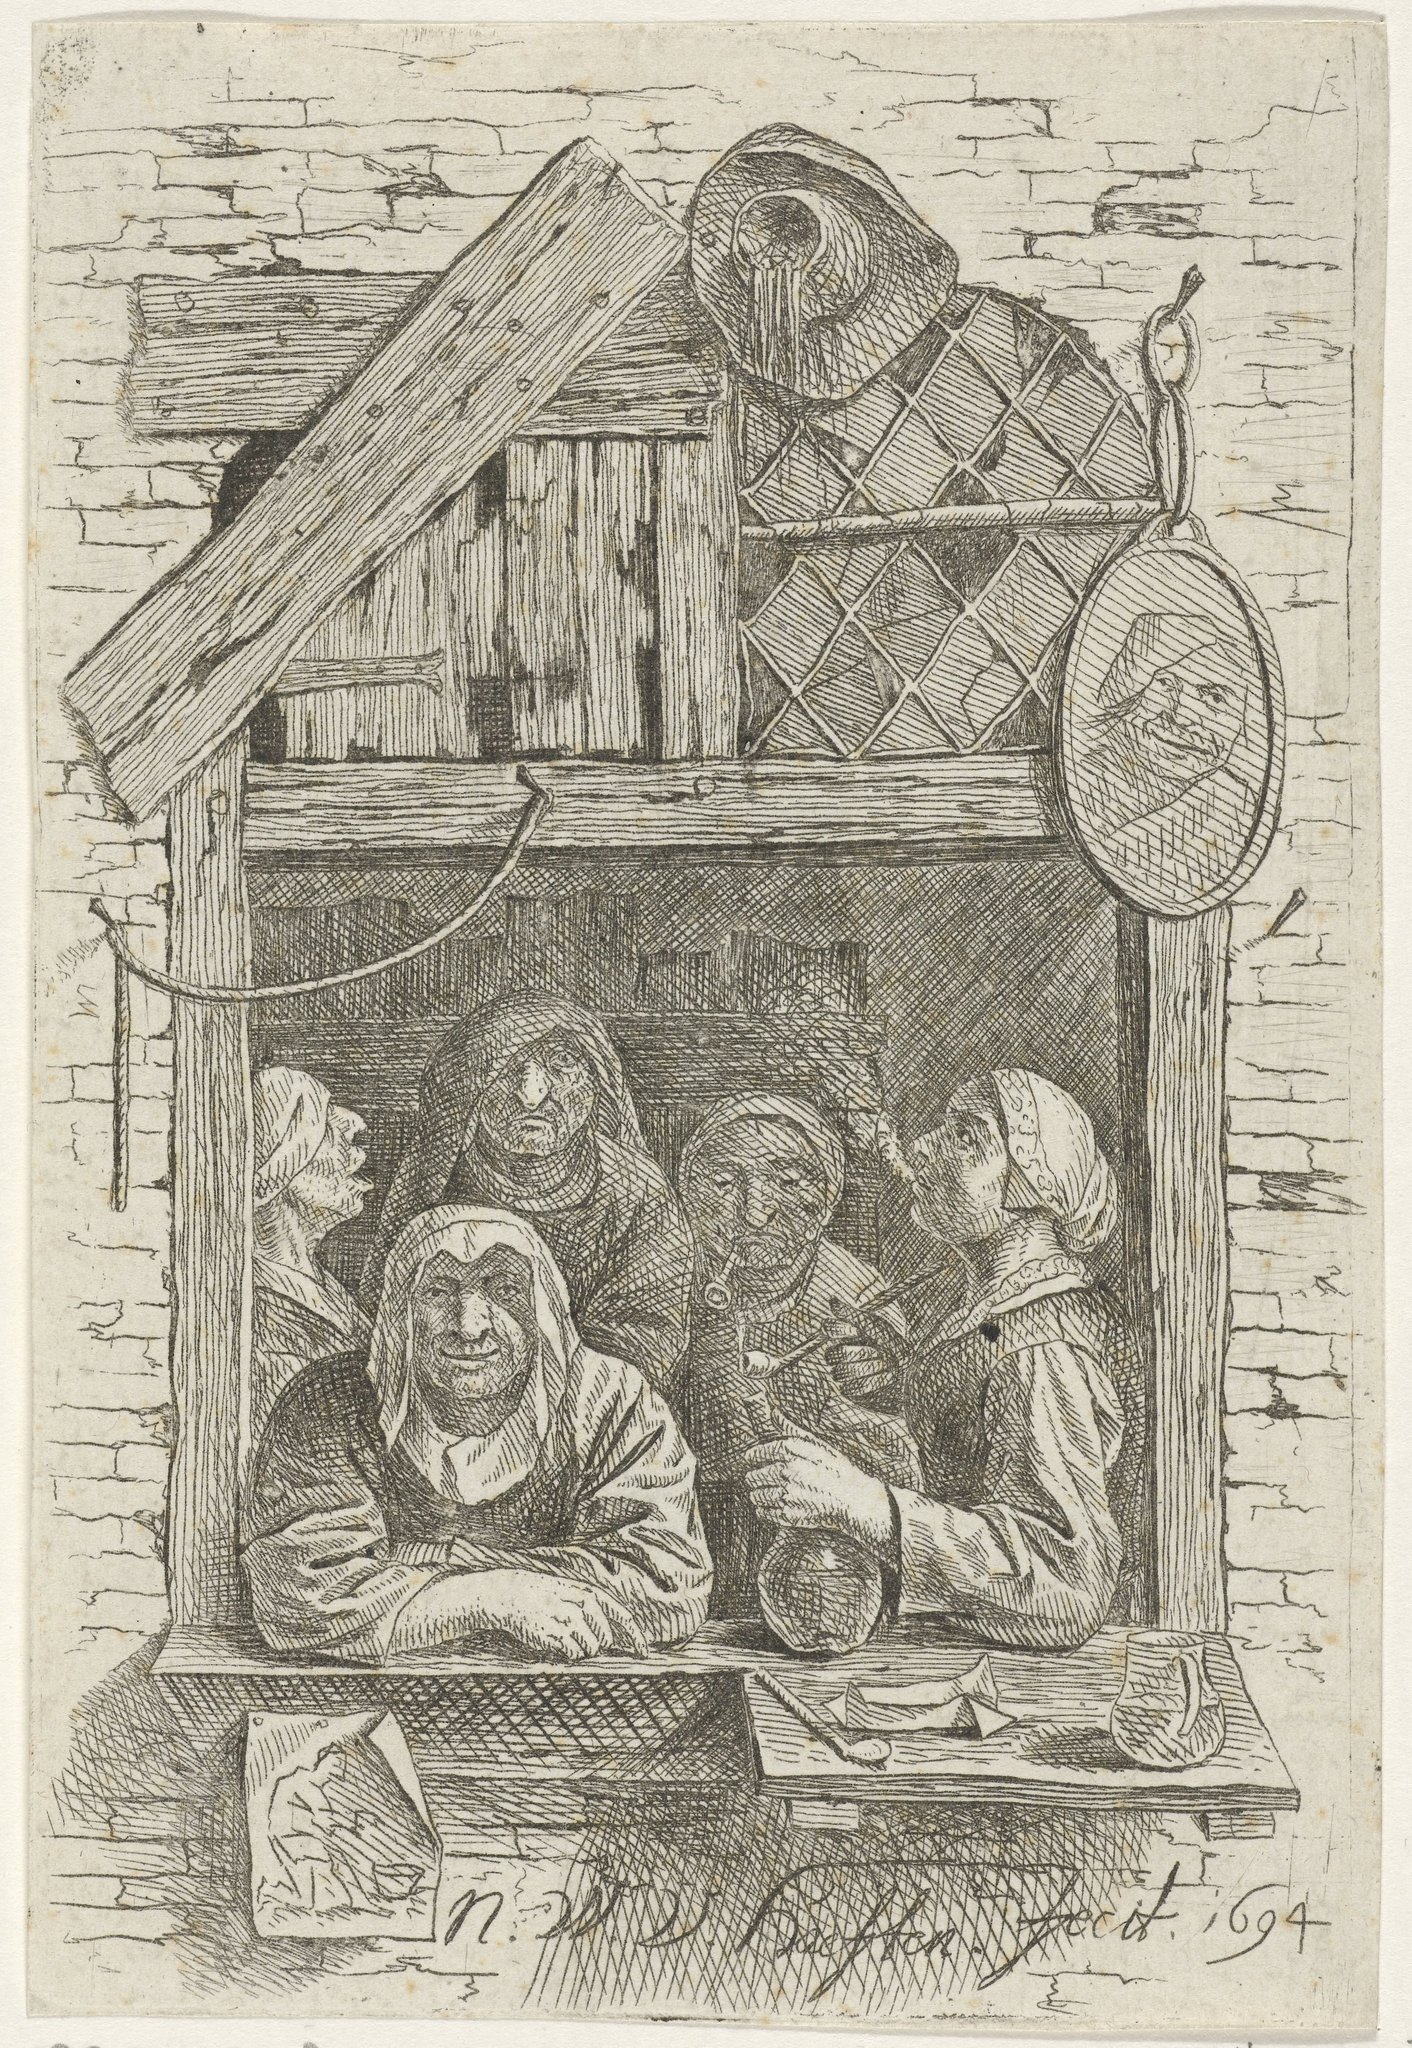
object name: print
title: Vijf vrouwen in een venster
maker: nicolaes van haeften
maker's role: draughtsman, painter, print maker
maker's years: 1653-1715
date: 1694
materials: paper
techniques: etching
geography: paris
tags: human figure at (open) window, seen from outside - aa - feigned window, pipe ~ tobacco (+ taking (particular) foodstuffs: eating, drinking, smoking, chewing, etc.)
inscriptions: collector's mark: Lugt 2228, collector's mark: Lugt 2760